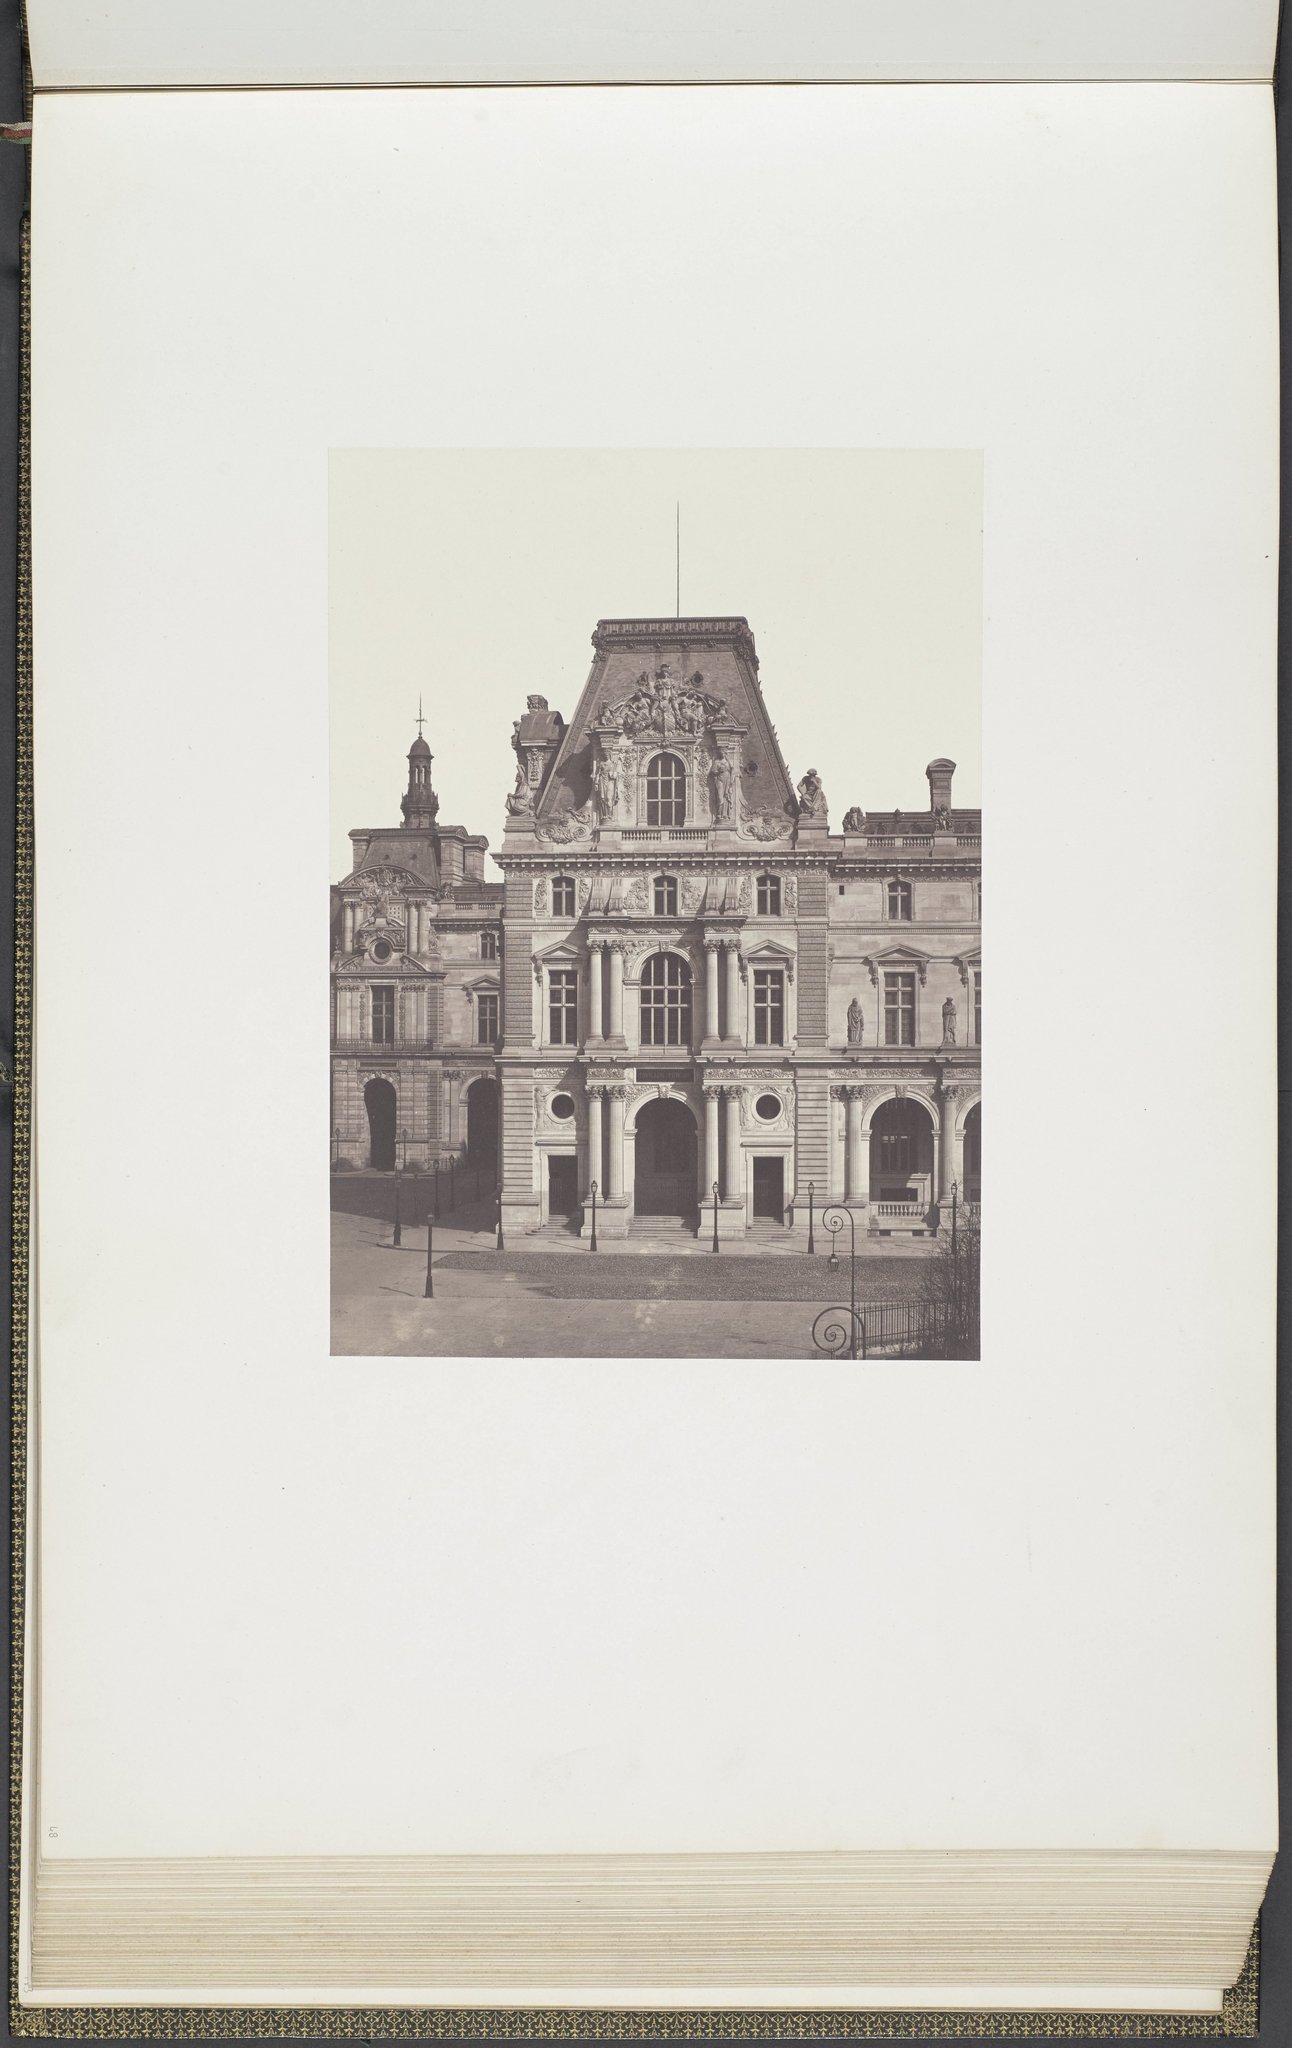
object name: album leaf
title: Pavillon Turgot in het Palais du Louvre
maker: édouard denis baldus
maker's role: fotograaf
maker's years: 1813-1889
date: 1857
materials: paper, photographic support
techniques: salted paper print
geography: paris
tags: permanent exhibition, museum, façade (of house or building), paris, tuileries palace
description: Onderdeel van Réunion des Tuileries au Louvre 1852-1857, album 1.